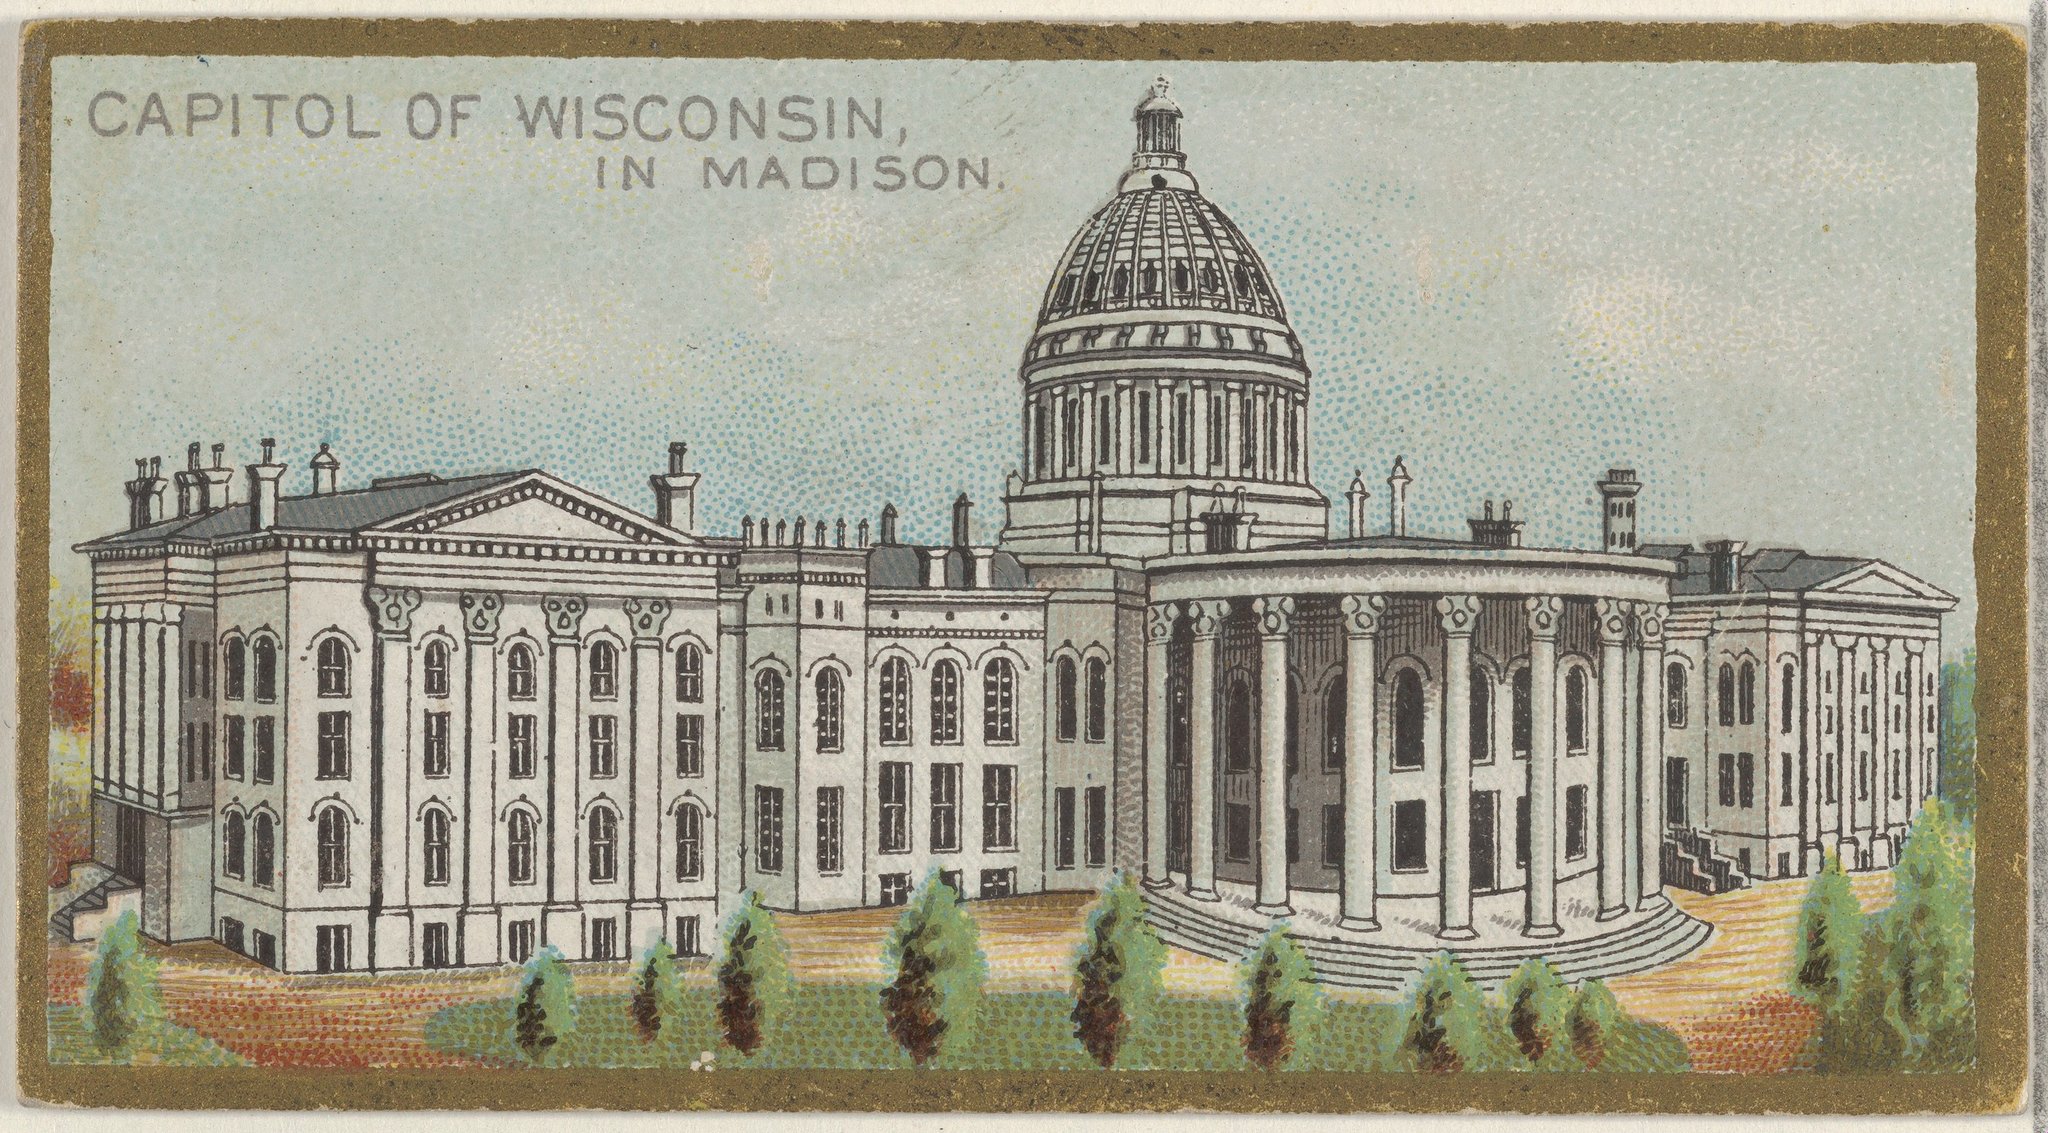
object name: print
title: Capitol of Wisconsin in Madison, from the General Government and State Capitol Buildings series (N14) for Allen & Ginter Cigarettes Brands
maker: allen & ginter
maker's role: publisher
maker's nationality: american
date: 1889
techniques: color lithograph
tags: buildings